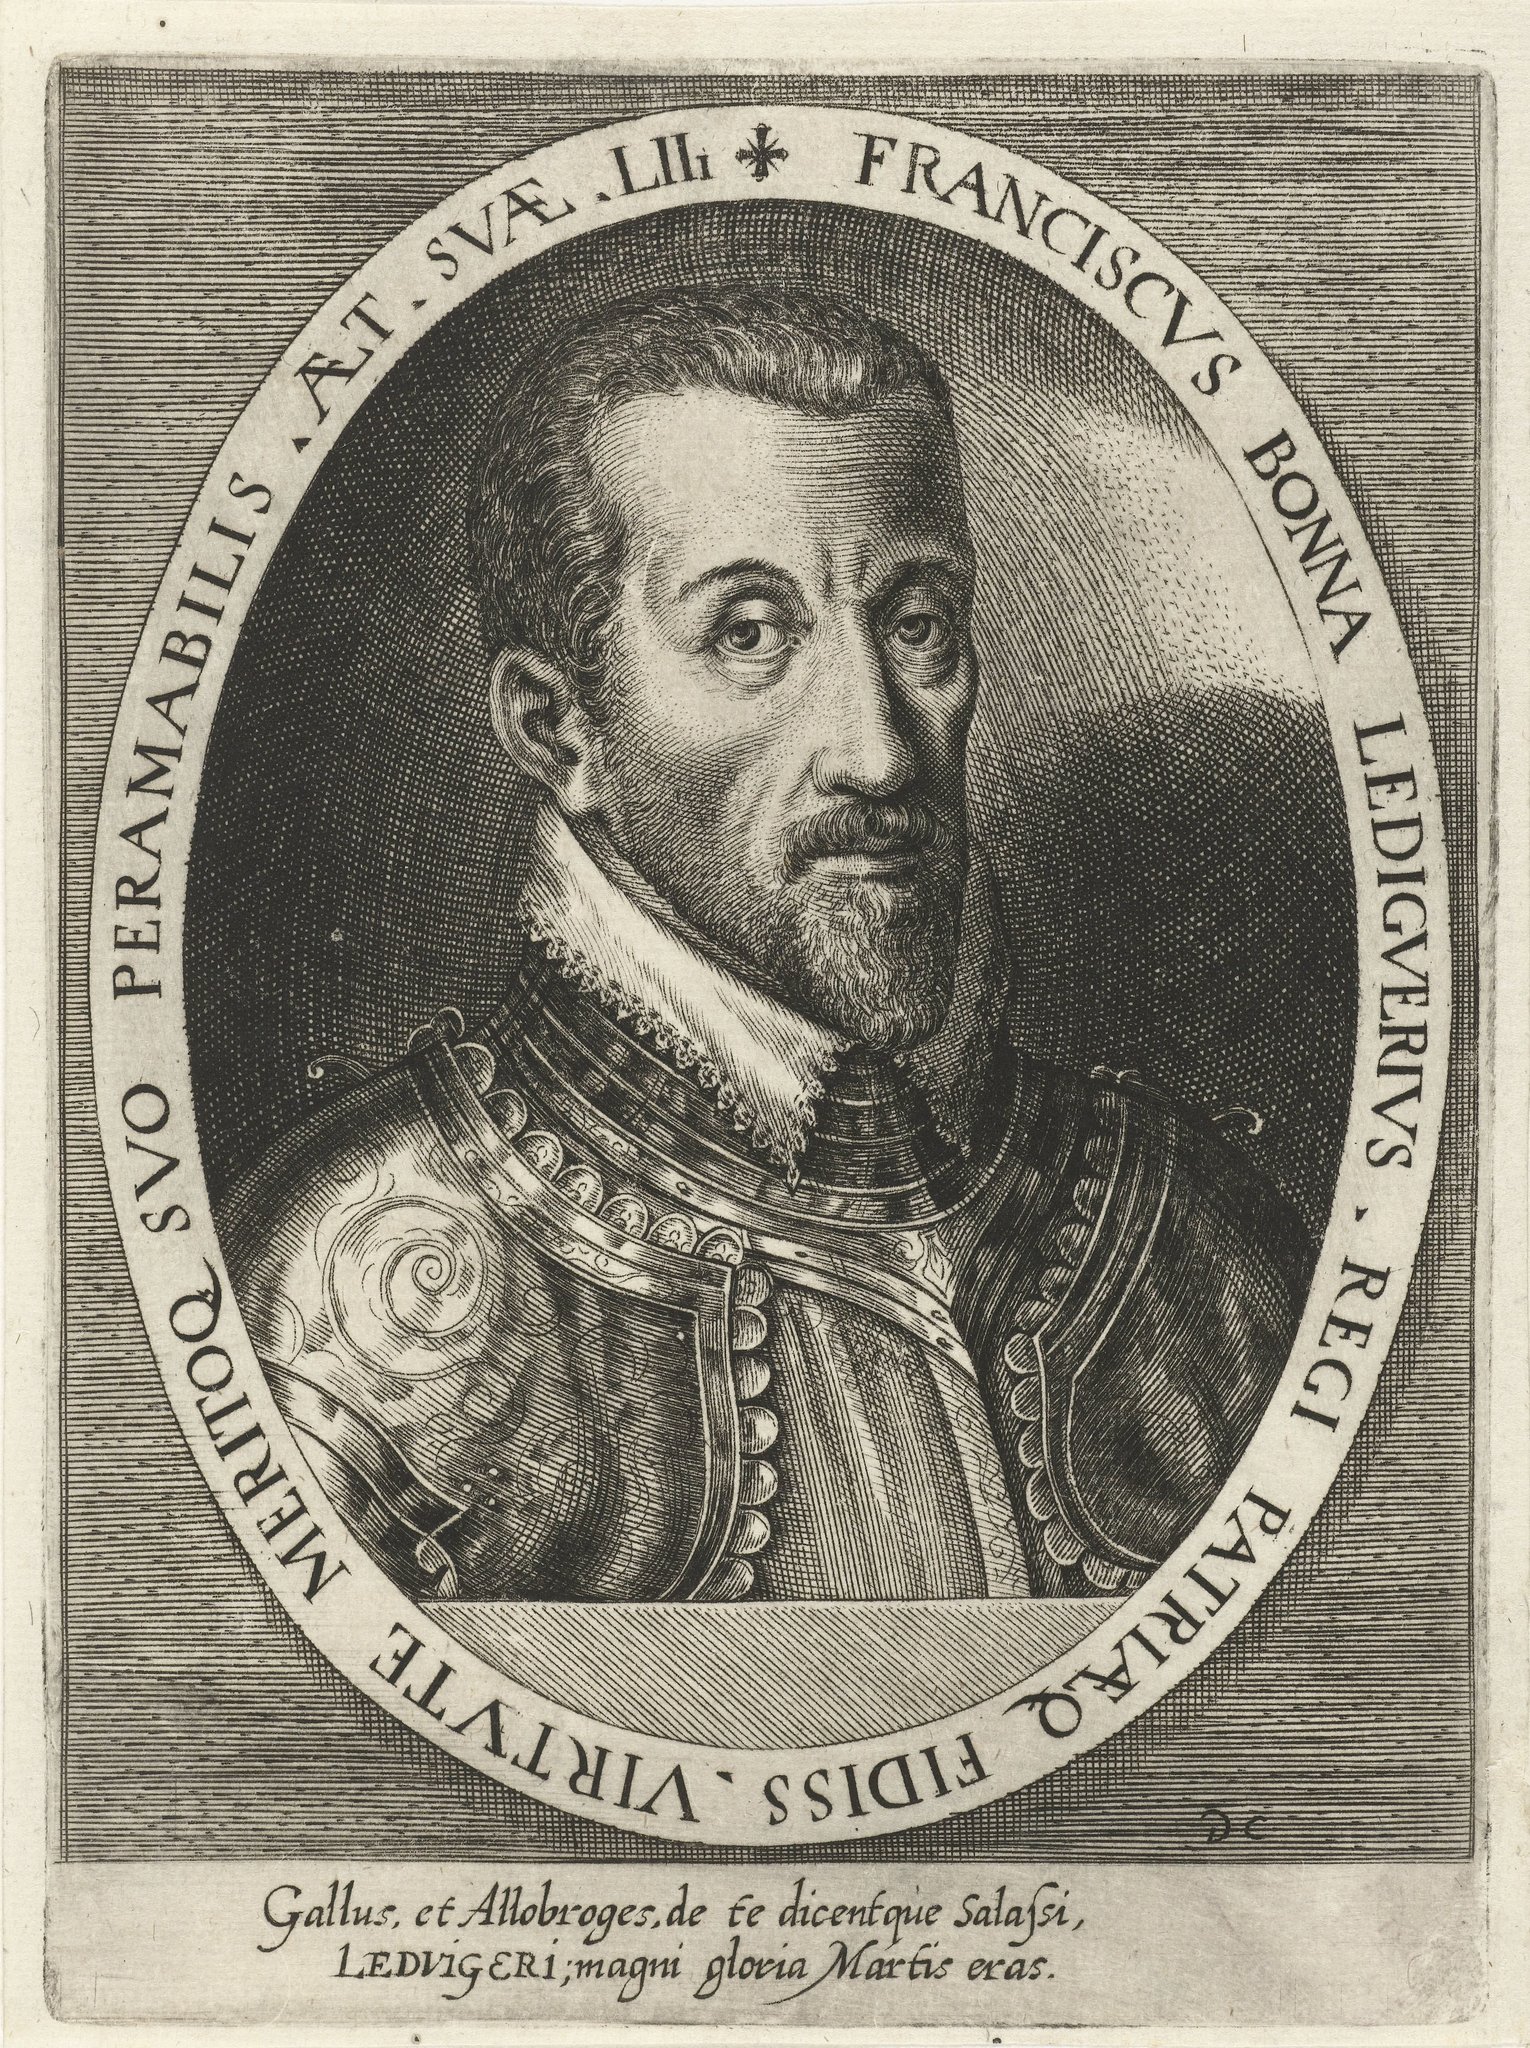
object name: print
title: Atrium Heroicum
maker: dominicus custos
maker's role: print maker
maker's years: 1560-1615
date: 1600-1604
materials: paper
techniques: engraving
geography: augsburg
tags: hertog, maarschalk, françois de bonne hertog van lesdiguières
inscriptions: collector's mark: Lugt 240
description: Illustratie uit: D. Custos en M. Henning. Atrium heroicum Caesarum, regum aliorq. summatum ac procerum qui intra proximum seculum vixere, aut hodie supersunt, imaginib. Deel 1-4. Augsburg: D. Custos, 1600-1604.